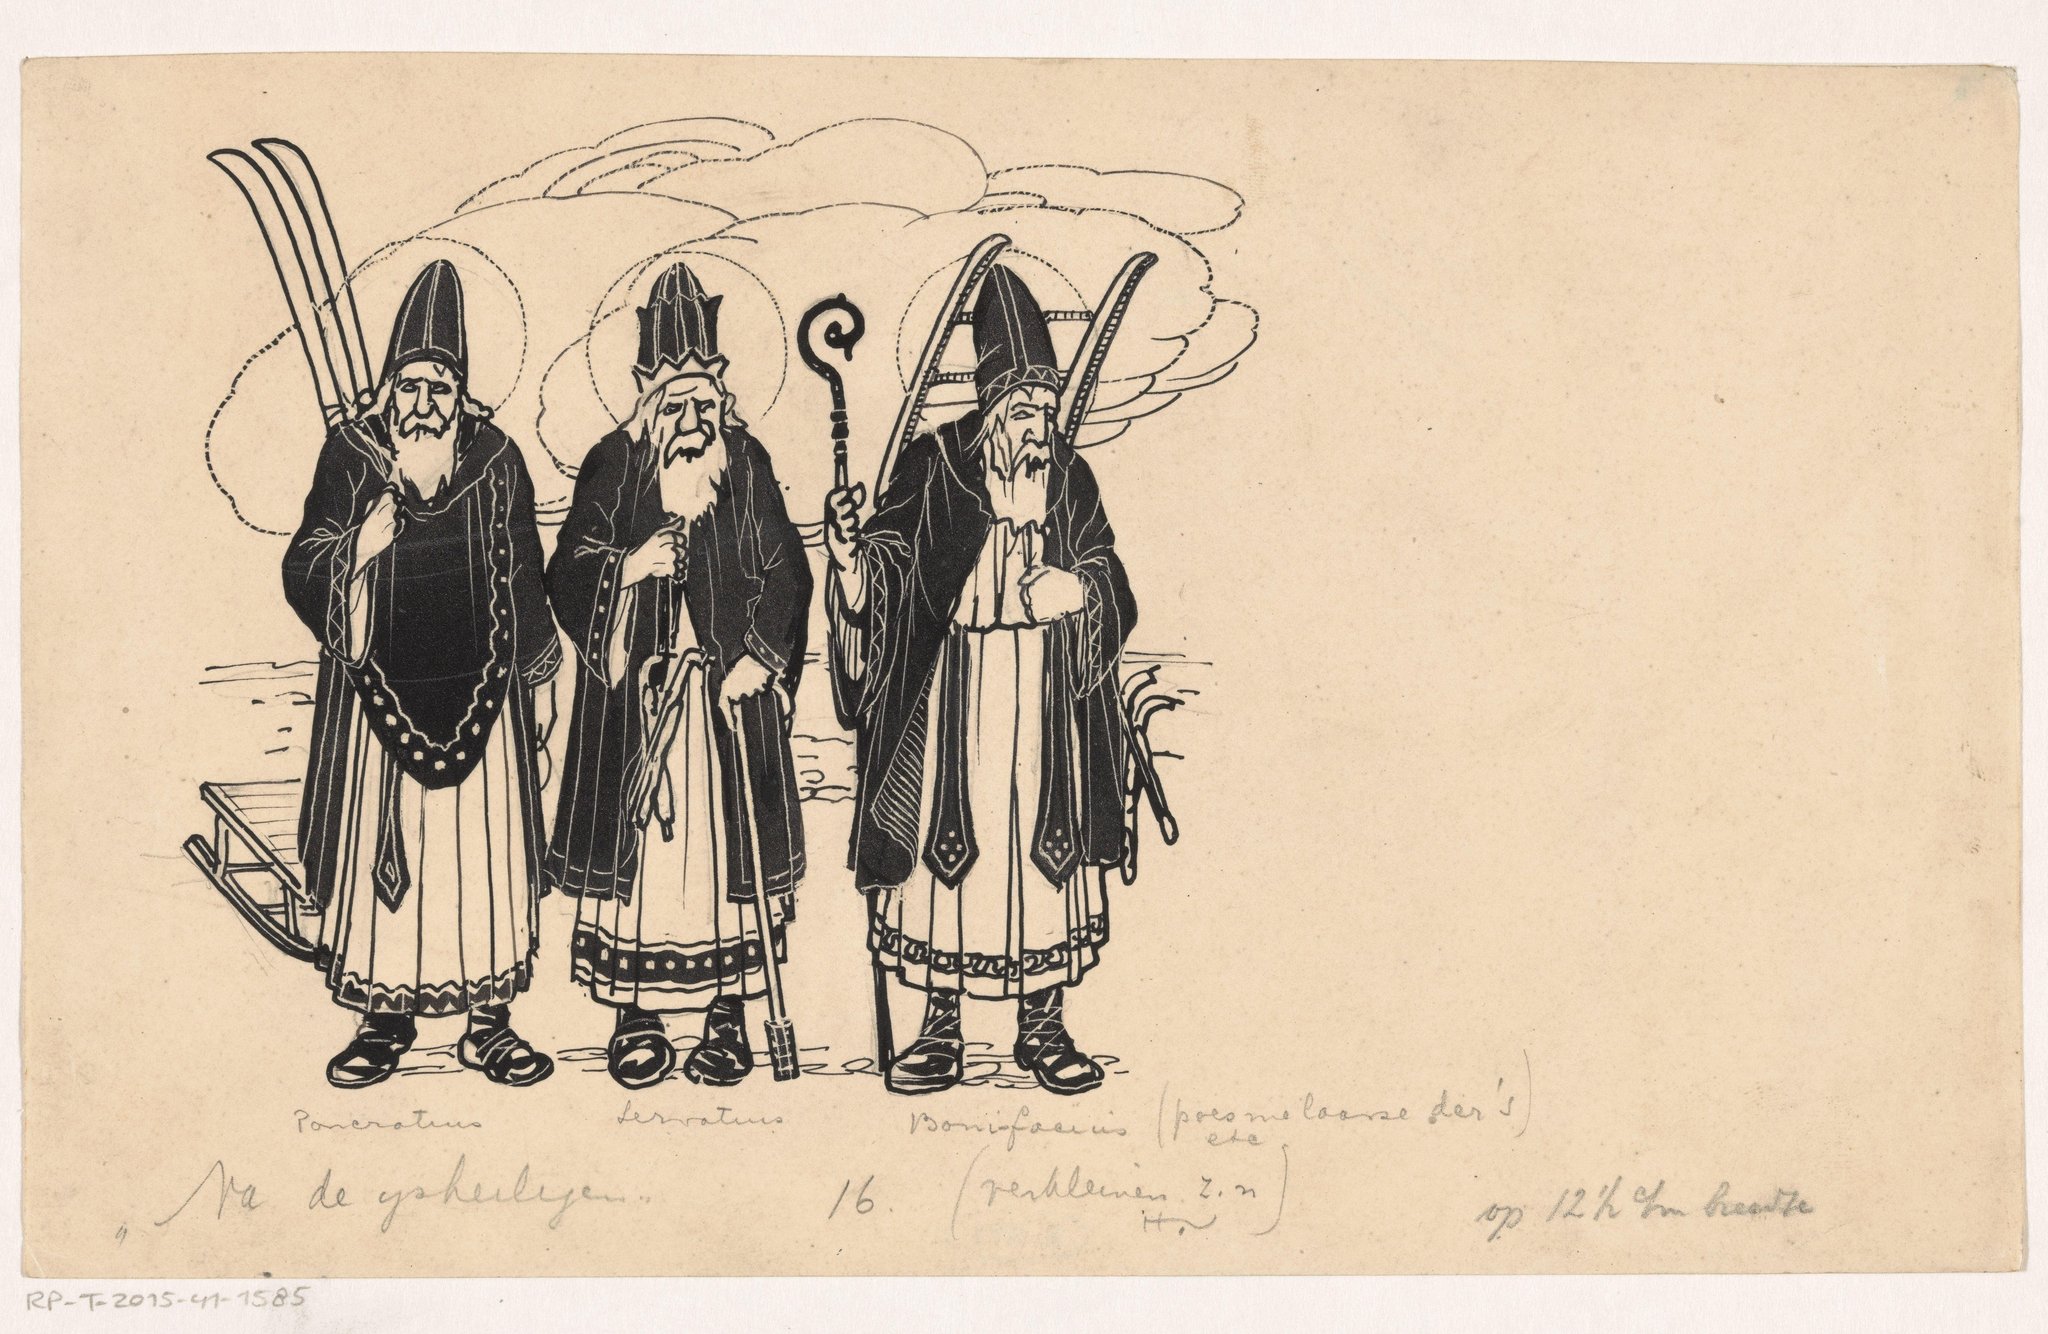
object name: boekillustratie ontwerp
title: IJsheiligen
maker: henri verstijnen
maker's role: draughtsman, print maker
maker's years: 1882-1940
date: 1892-1940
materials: ink, paper, pencil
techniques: brush, pen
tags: the martyr pancras (pancratius) of rome; possible attributes: sword, the martyr boniface, 'apostle of germany', and archbishop of mainz; possible attributes: axe in root of tree, book pierced by a sword, fountain (springing up from under his staff), whip, servatius, bishop of tongeren and maastricht; possible attributes: clog (wooden shoe), dragon, eagle, key, sledge, sleigh (winter sports)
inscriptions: annotation: ‘Pancrattius Servatius Bonifacius (poes me laarze der 's)/ "Na de ijsheiligen" 16’, collector's mark: Lugt 2228, :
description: Sint Pancratius, Sint Servatius en Sint Bonifatius, allen met een baard, staan op een rij. Ze dragen een staf, stok, ski's en een slee.